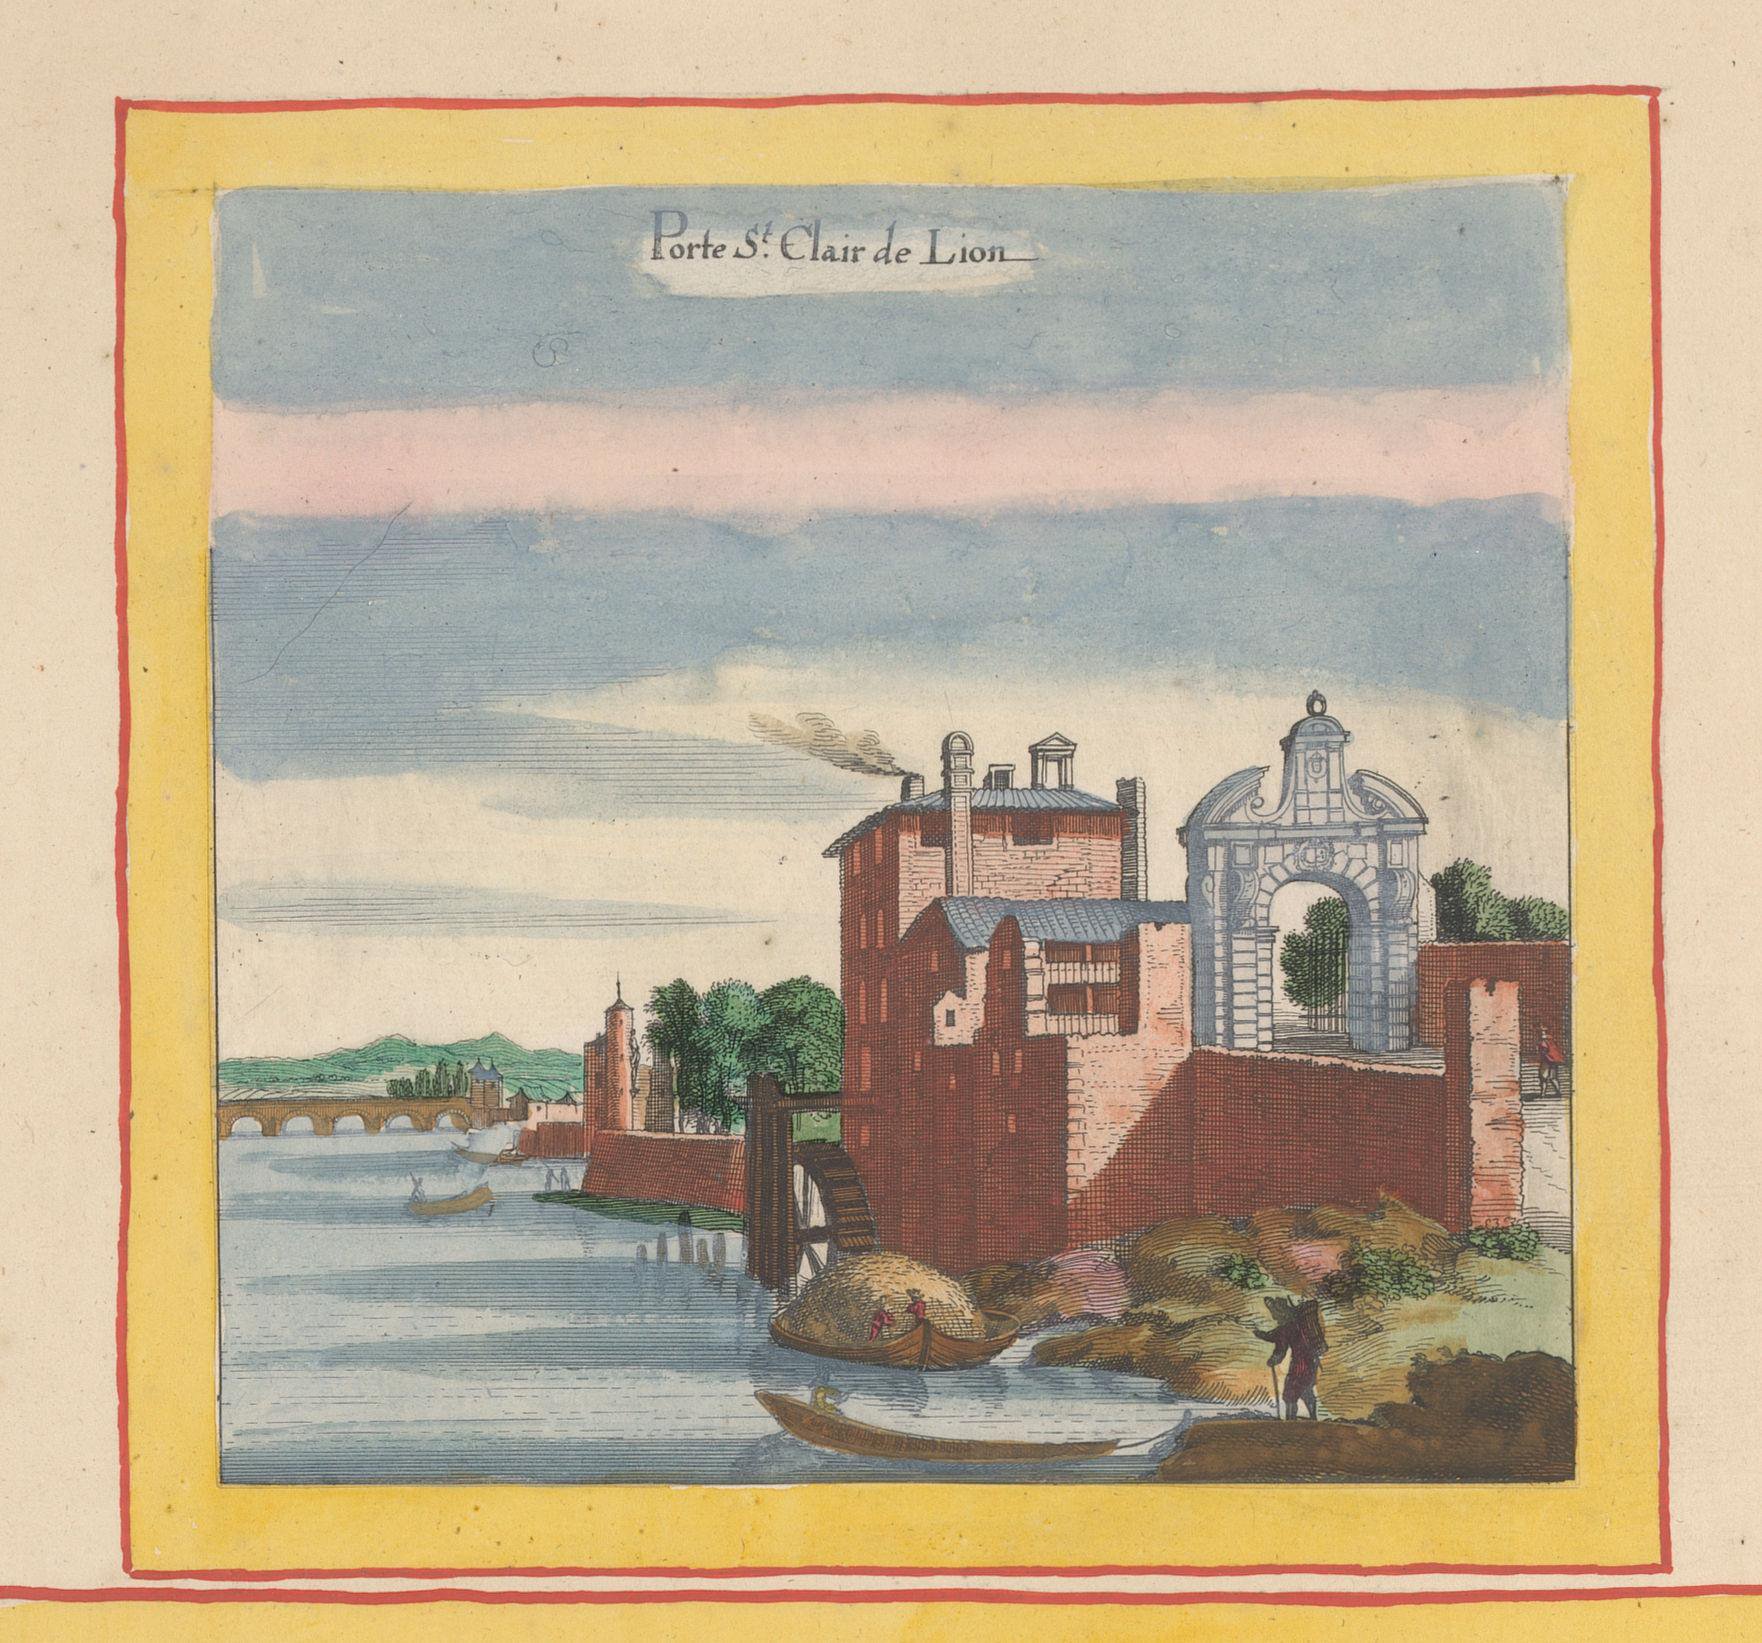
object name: print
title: Gezicht op een van de stadspoorten van Lyon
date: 1657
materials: paper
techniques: engraving, etching, hand coloring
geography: the hague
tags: gate ~ fortified city, city-view in general; 'veduta', city-gate, lyon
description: Prent uit: Zeiller, Martin. Topographia Galliae. 13 dln. Frankfurt: Caspar Merian, 1657, dl. 5, na p. 20. De titel is uit de originele prent gesneden. Boven de gravure is een deel lucht en wolken (bij)geschilderd, waarin de titel gelijmd is. Origineel gedrukt op één blad met een gezicht op het fort Saint-Jean.